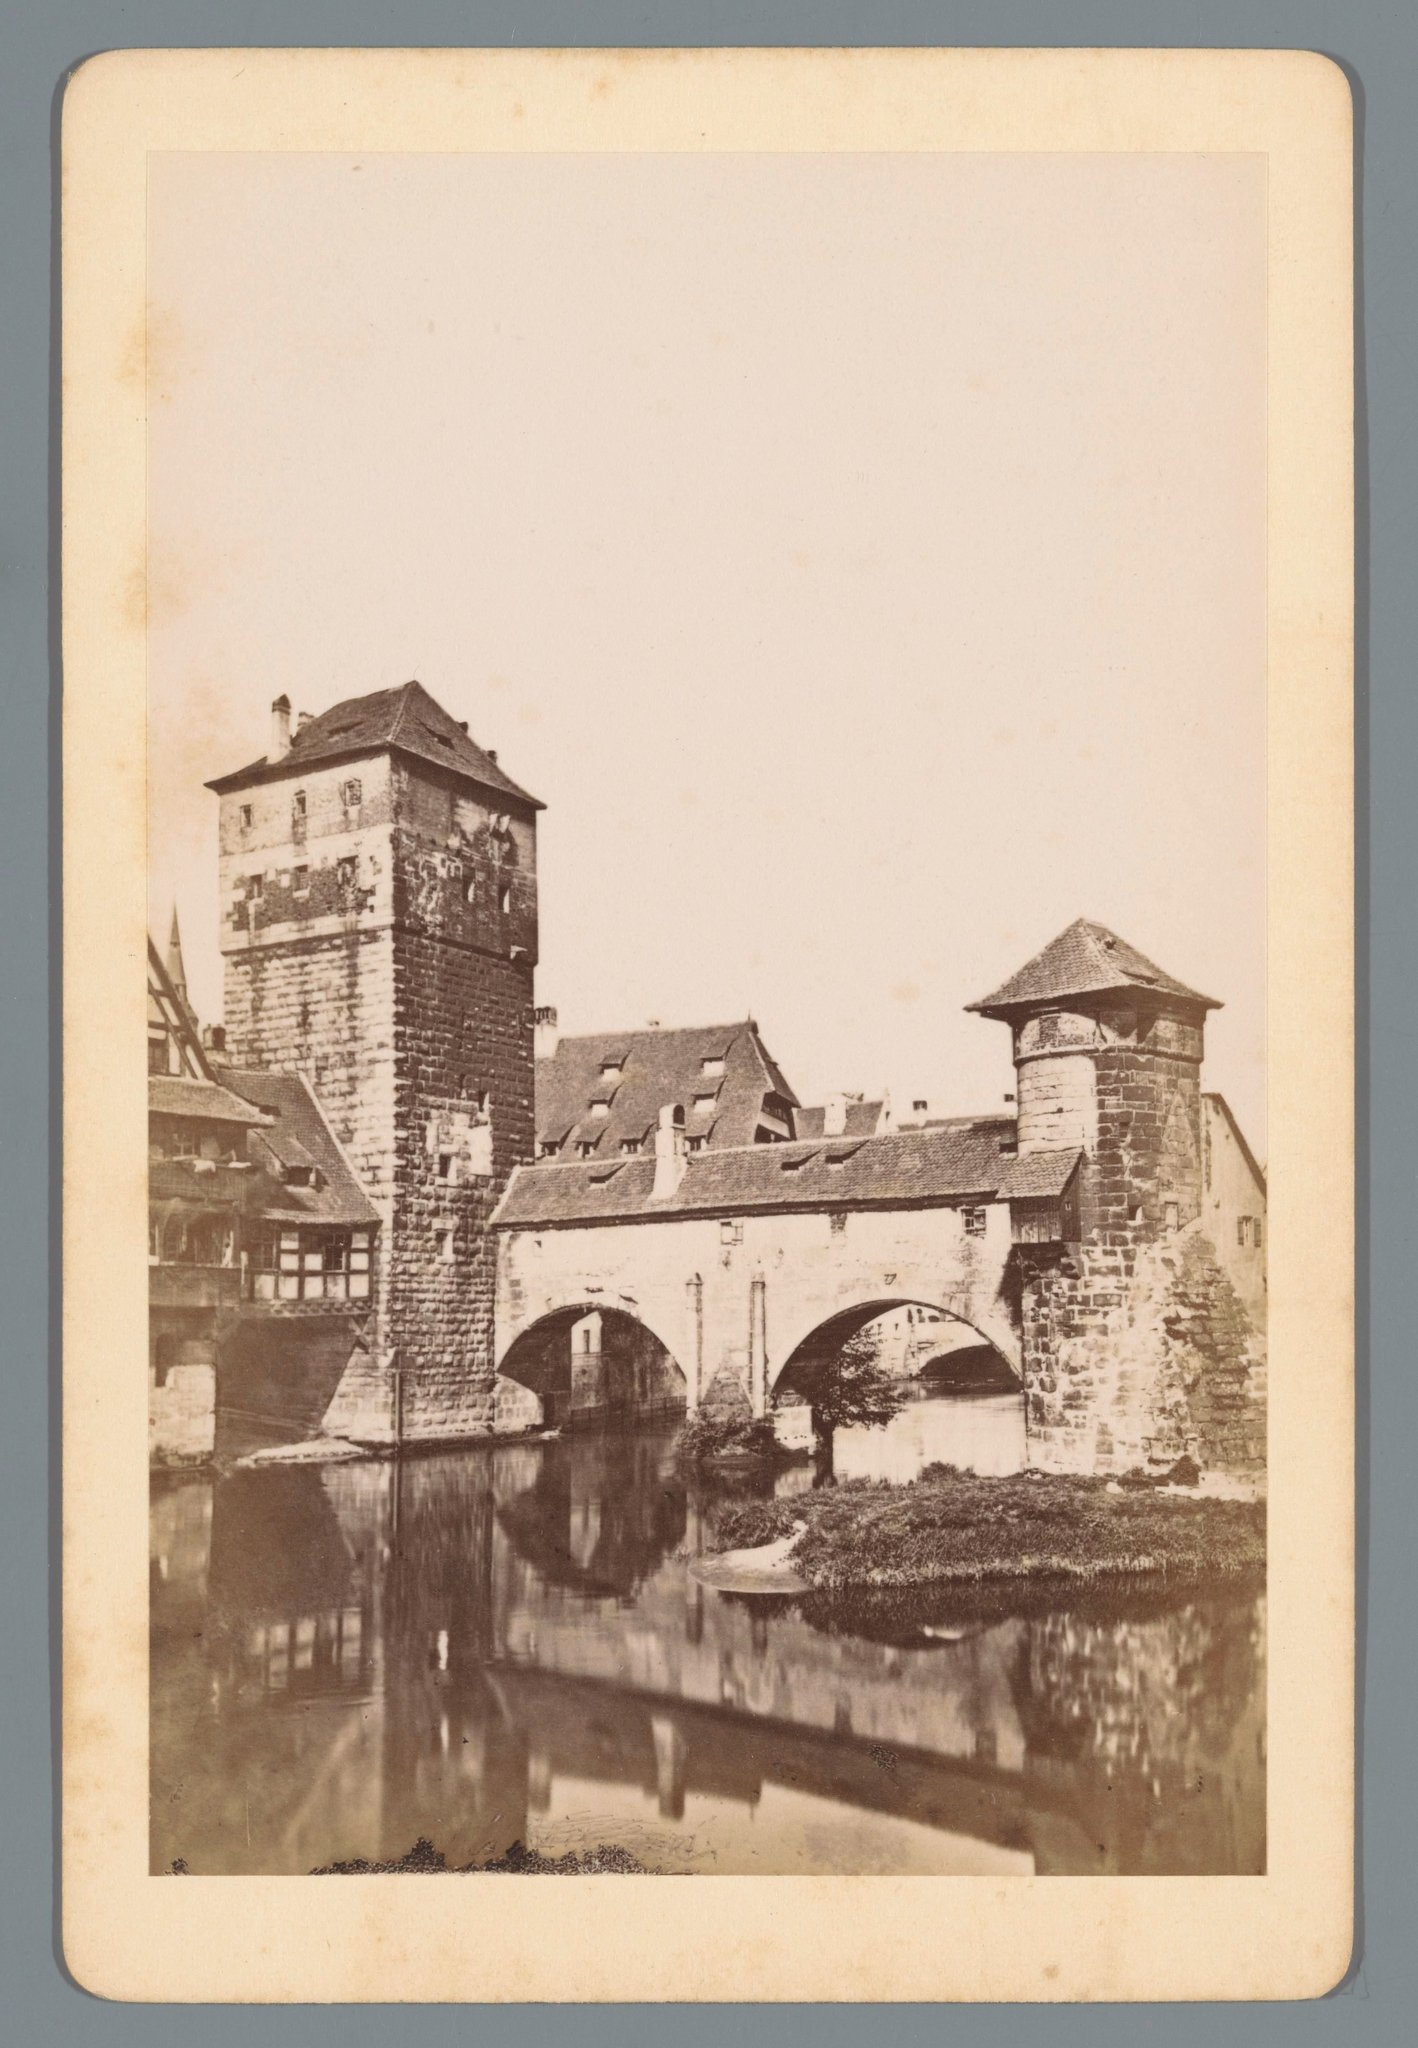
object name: cabinet photograph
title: Nürnberg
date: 1863-1898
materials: cardboard, photographic support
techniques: albumen print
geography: nuremberg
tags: water tower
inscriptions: number: ‘16.’